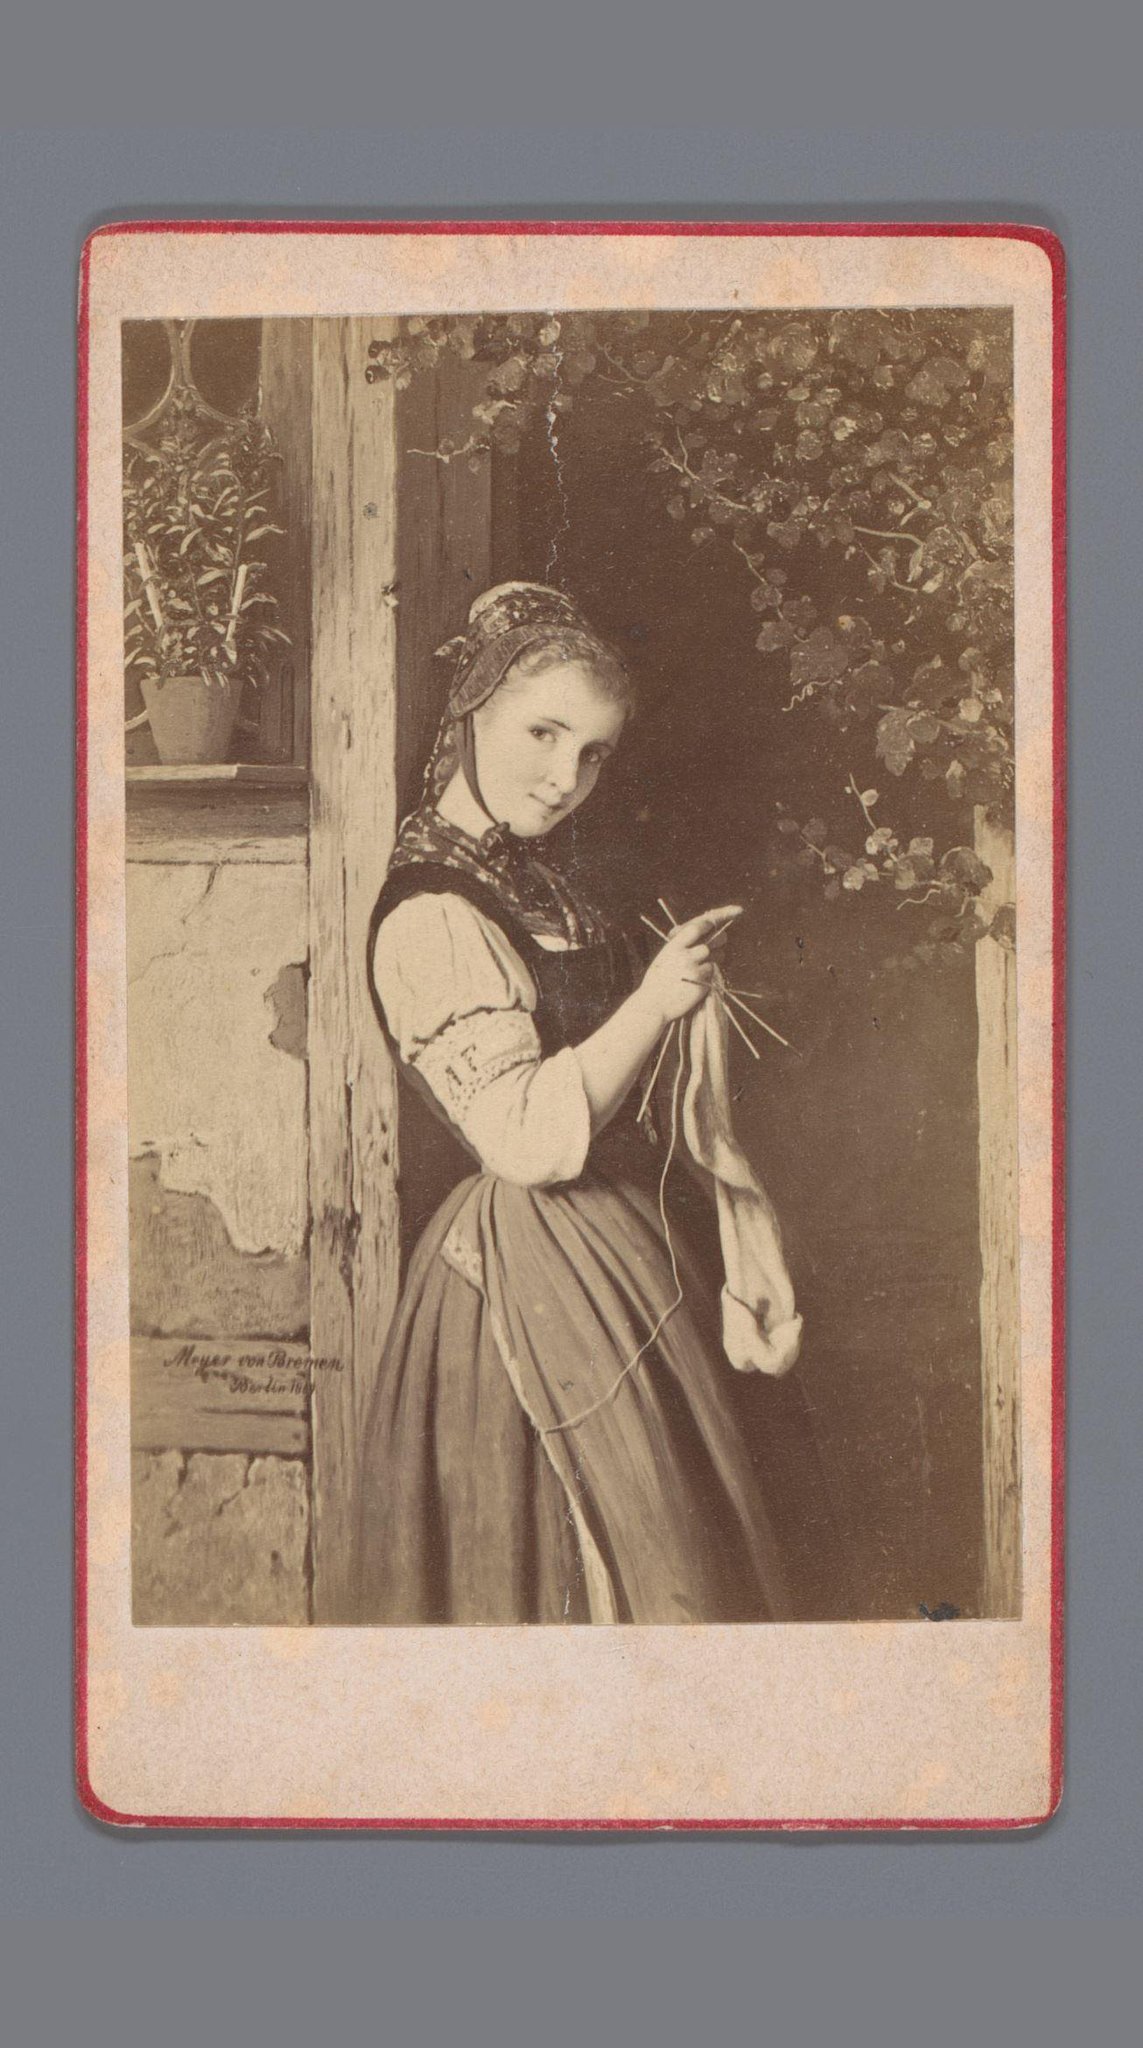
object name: photograph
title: Meyer Bremen. Die Strickerin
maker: Anonymous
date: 1869-1885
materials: cardboard, paper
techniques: albumen print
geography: berlin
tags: girl (child between toddler and youth), knitting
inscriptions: inscription: ‘Kunst-Verlag/ der Photographischen Gesellschaft/ Berlin/ am Dönhofsplatz.’, number: ‘42’, monogram: ‘PG’